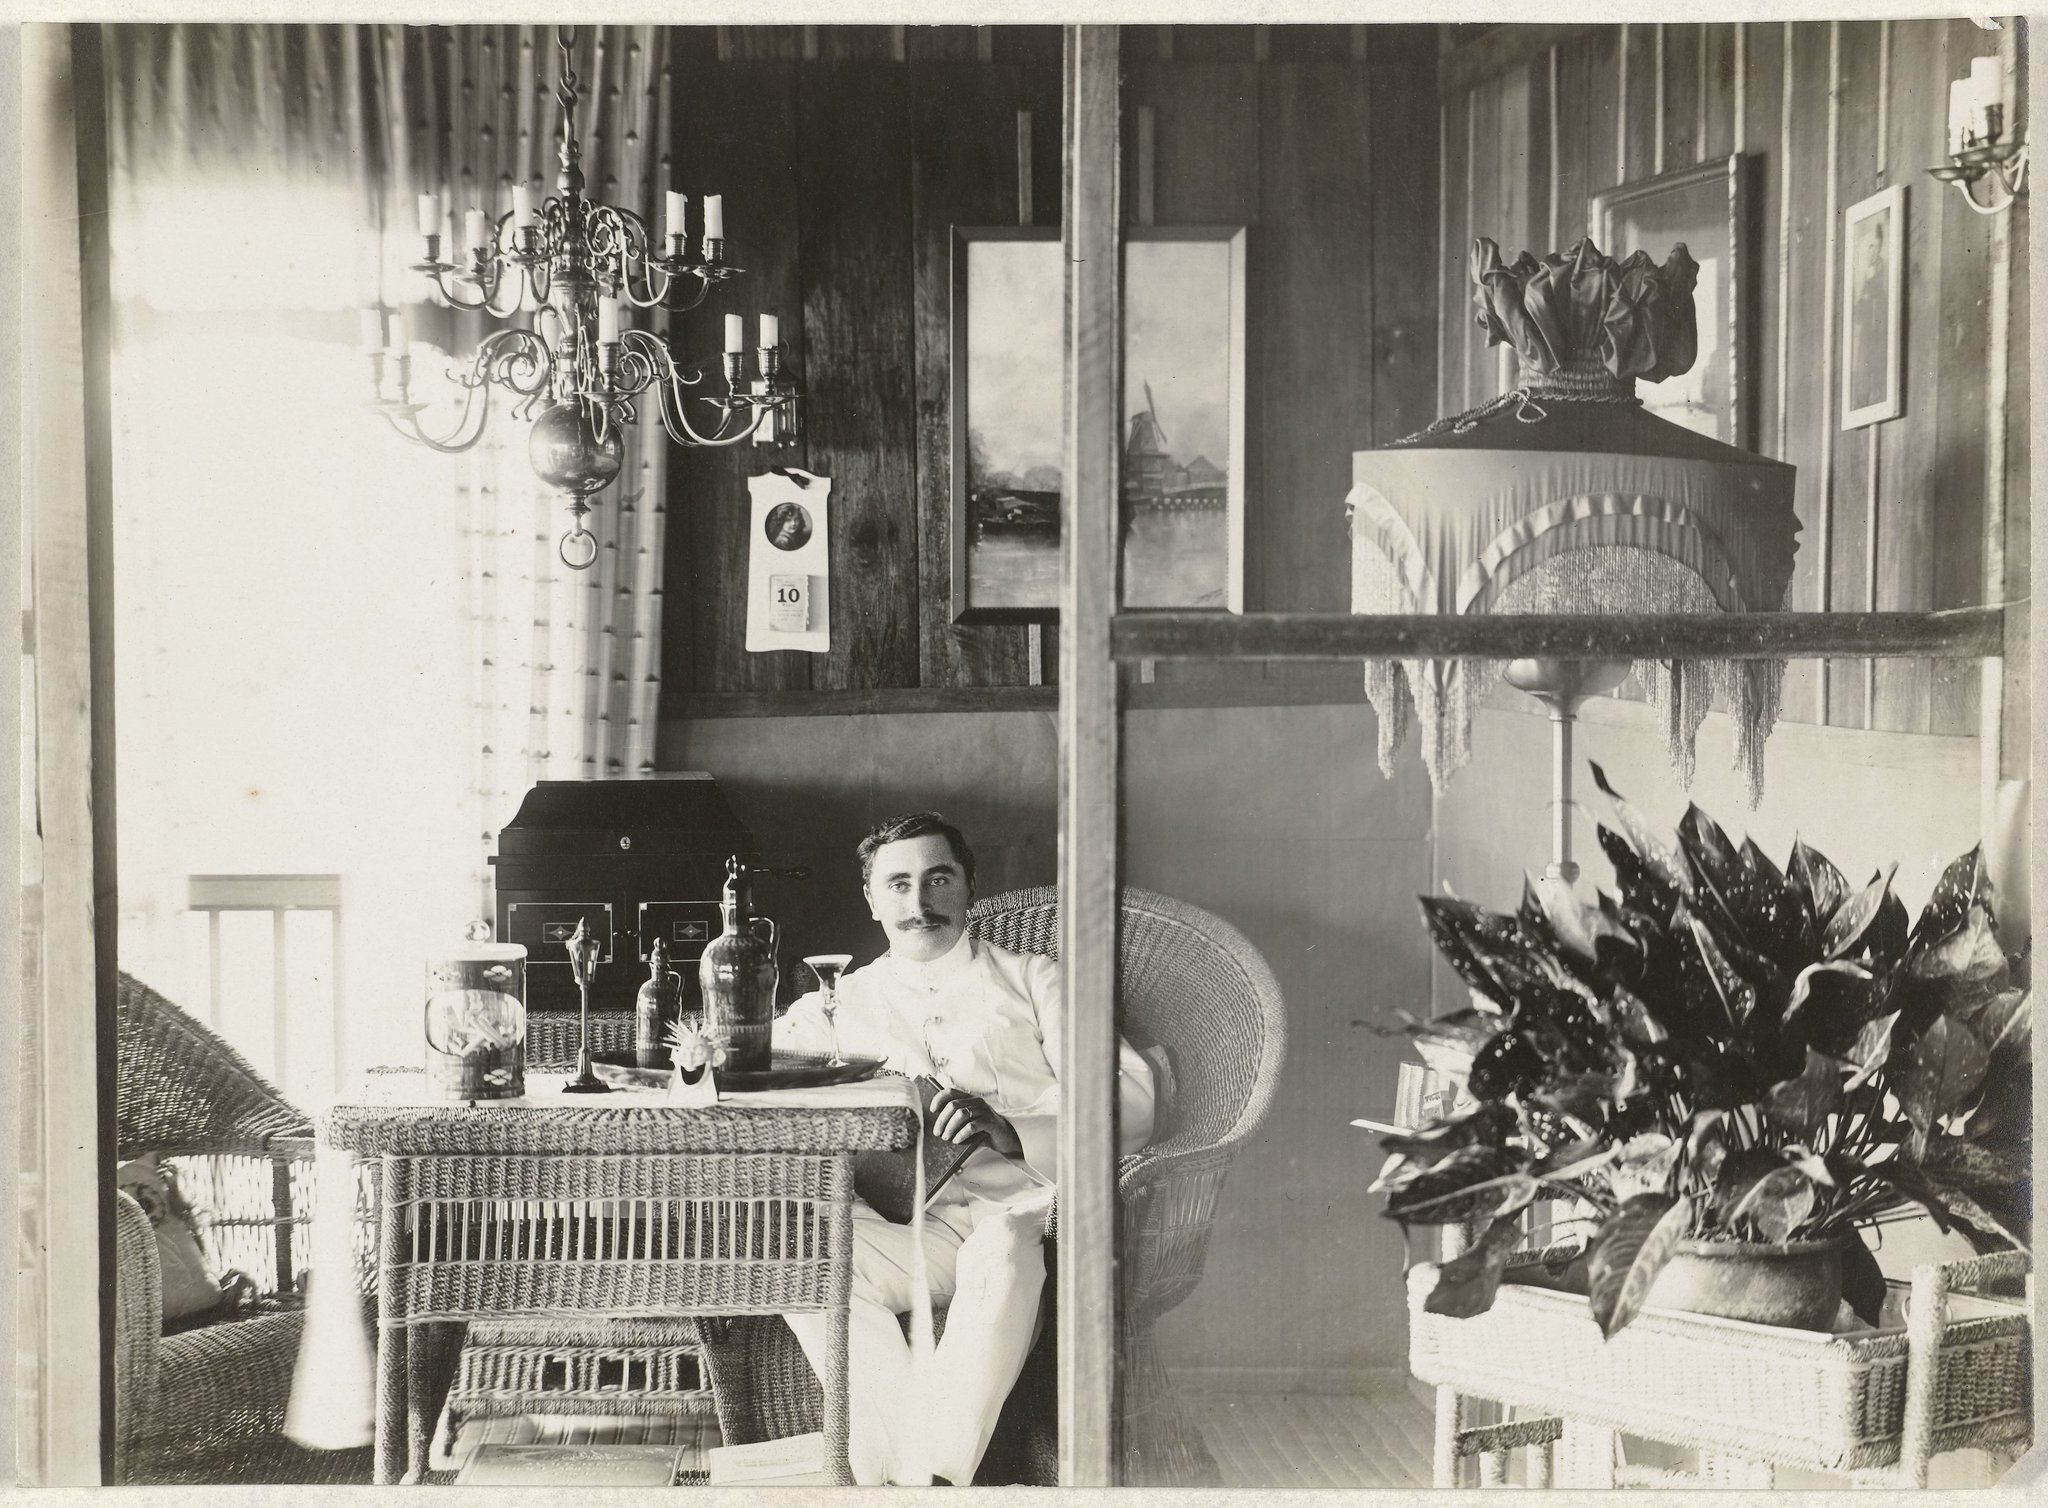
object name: photograph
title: Portret van een onbekende man in een tropenpak in een interieur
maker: Anonymous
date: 1885-1910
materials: paper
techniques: gelatin silver print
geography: indonesia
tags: adult man, anonymous historical person portrayed, living-room, parlour, sitting-room, indonesia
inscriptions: inscription: ‘Mr S.P. Huijkman/ van/ Ferri’